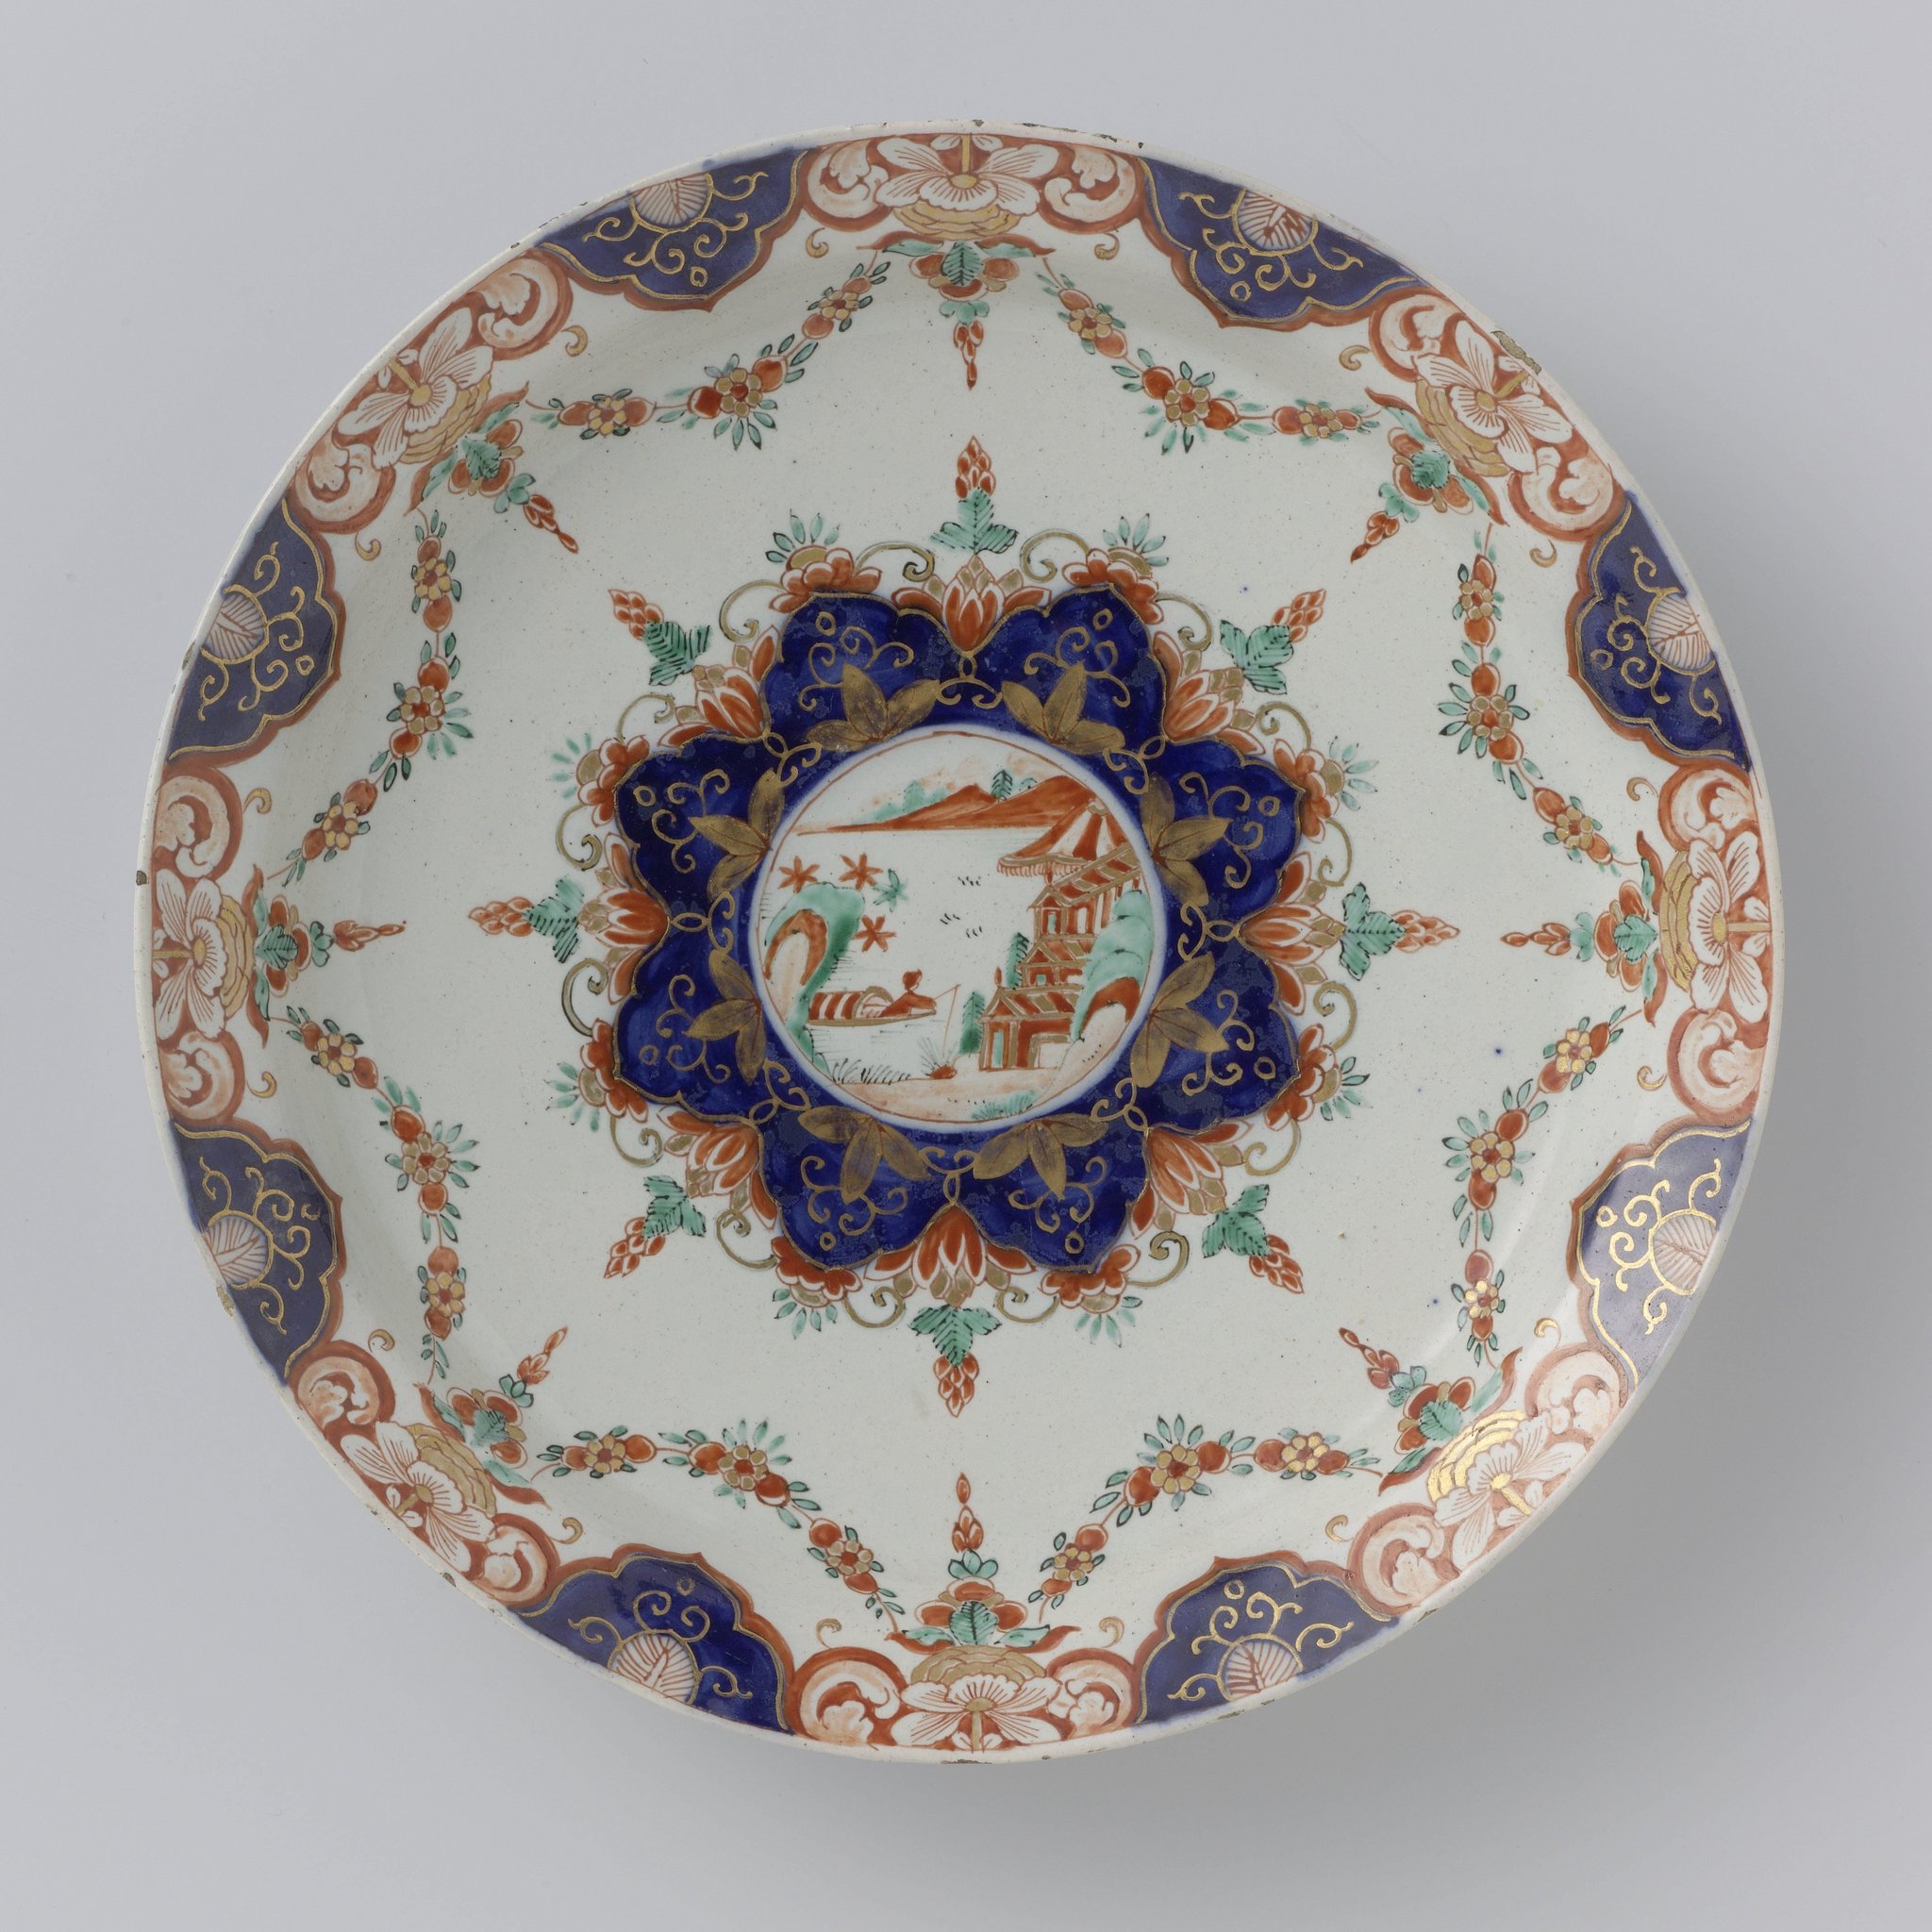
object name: plate dish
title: Bord van veelkleurig beschilderde faïence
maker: Anonymous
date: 1700-1725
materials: faience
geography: delft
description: Bord van faïence. Veelkleurig beschilderd met een chinees waterlandschap en lambrequins, in imari kleuren.